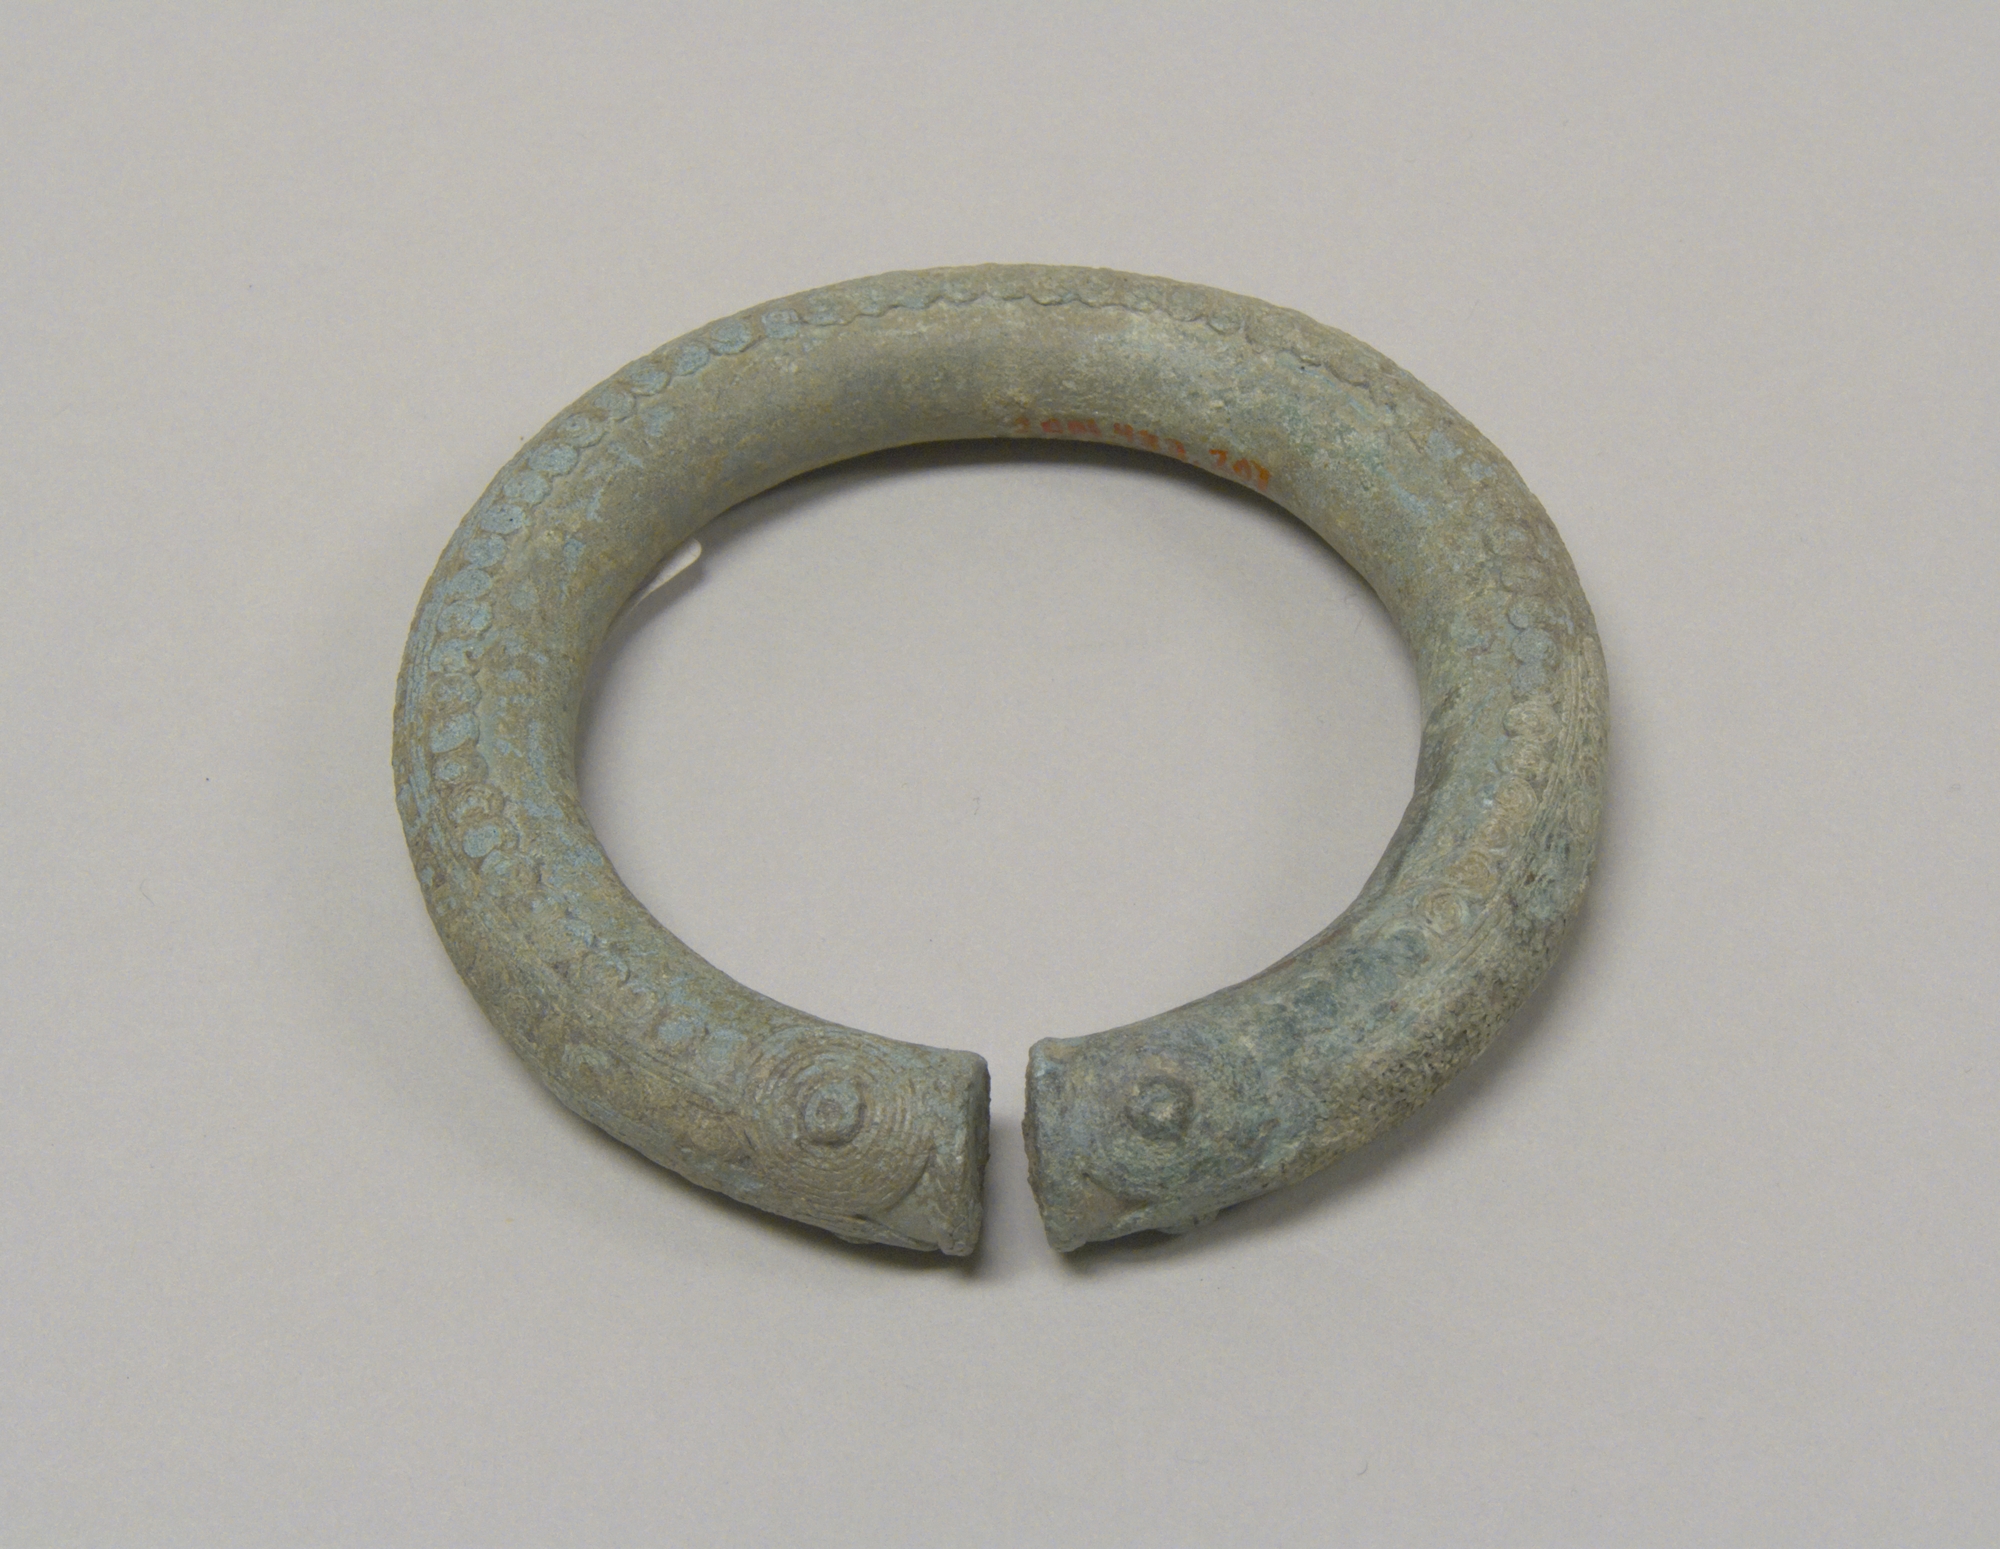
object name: one of a pair of bangle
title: One from a Pair of Bangles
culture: thai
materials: bronze